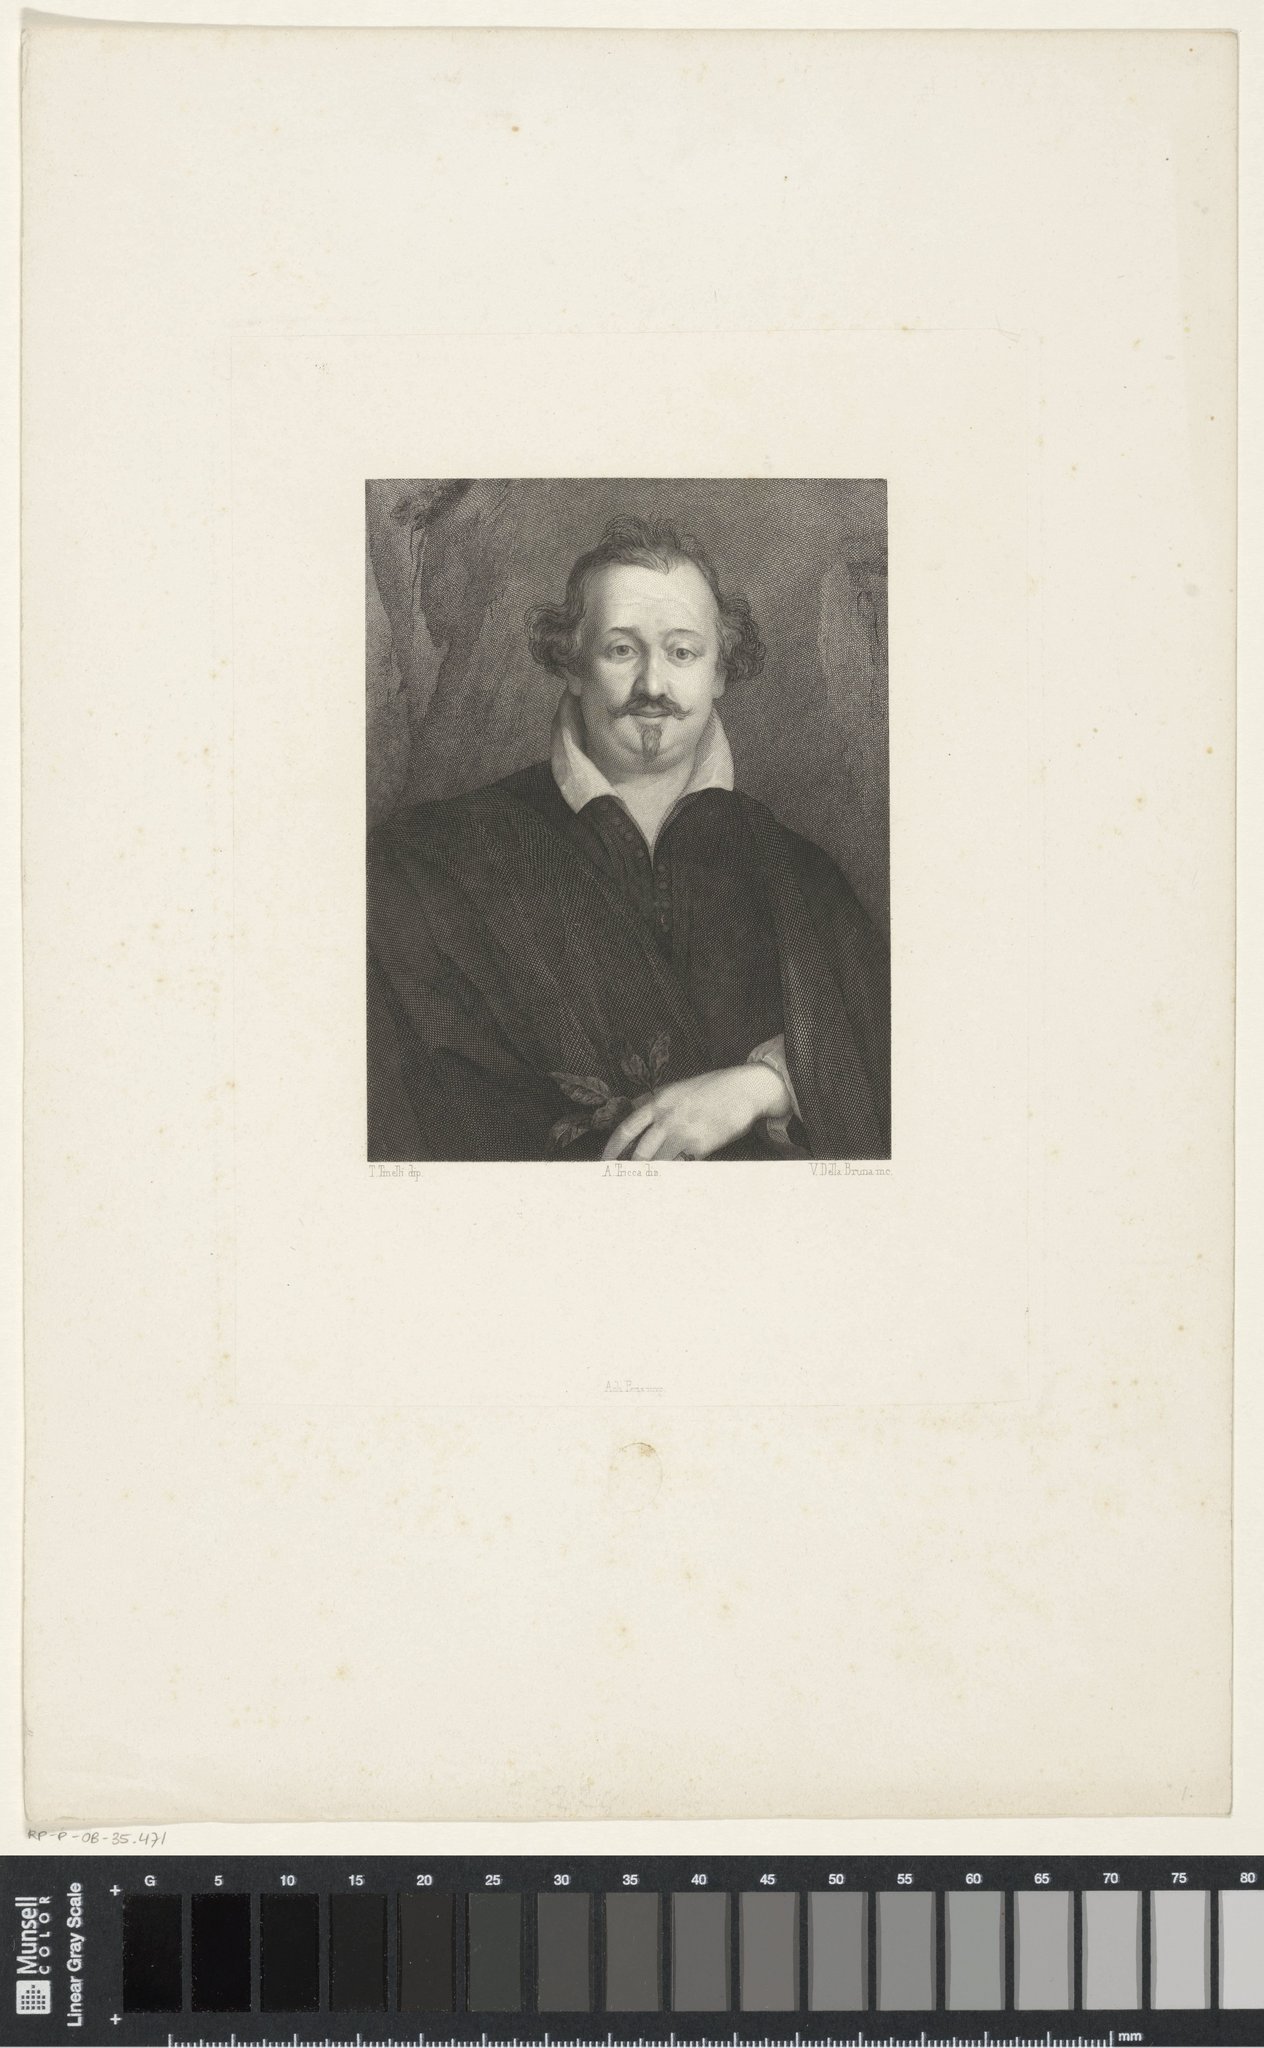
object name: print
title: Portret van een man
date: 1814-1870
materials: paper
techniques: engraving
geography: italy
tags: anonymous historical person portrayed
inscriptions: collector's mark, collector's mark: Lugt 2228